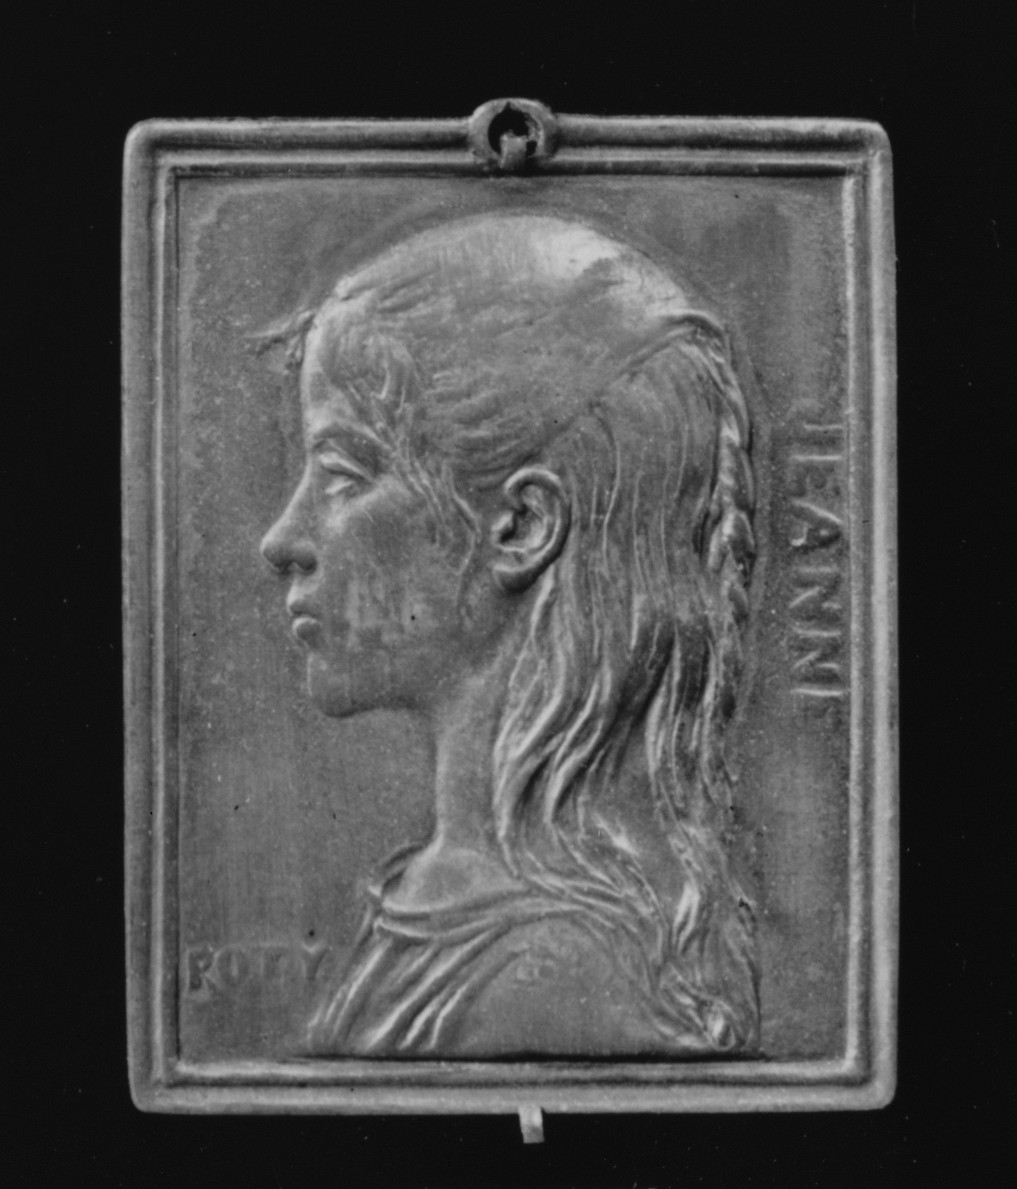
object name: plaquette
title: Jeanne (Roty?)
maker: louis-oscar roty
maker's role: artist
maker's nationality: french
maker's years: 1846-1911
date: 1801-1900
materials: bronze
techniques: casting, silvered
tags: profiles,women